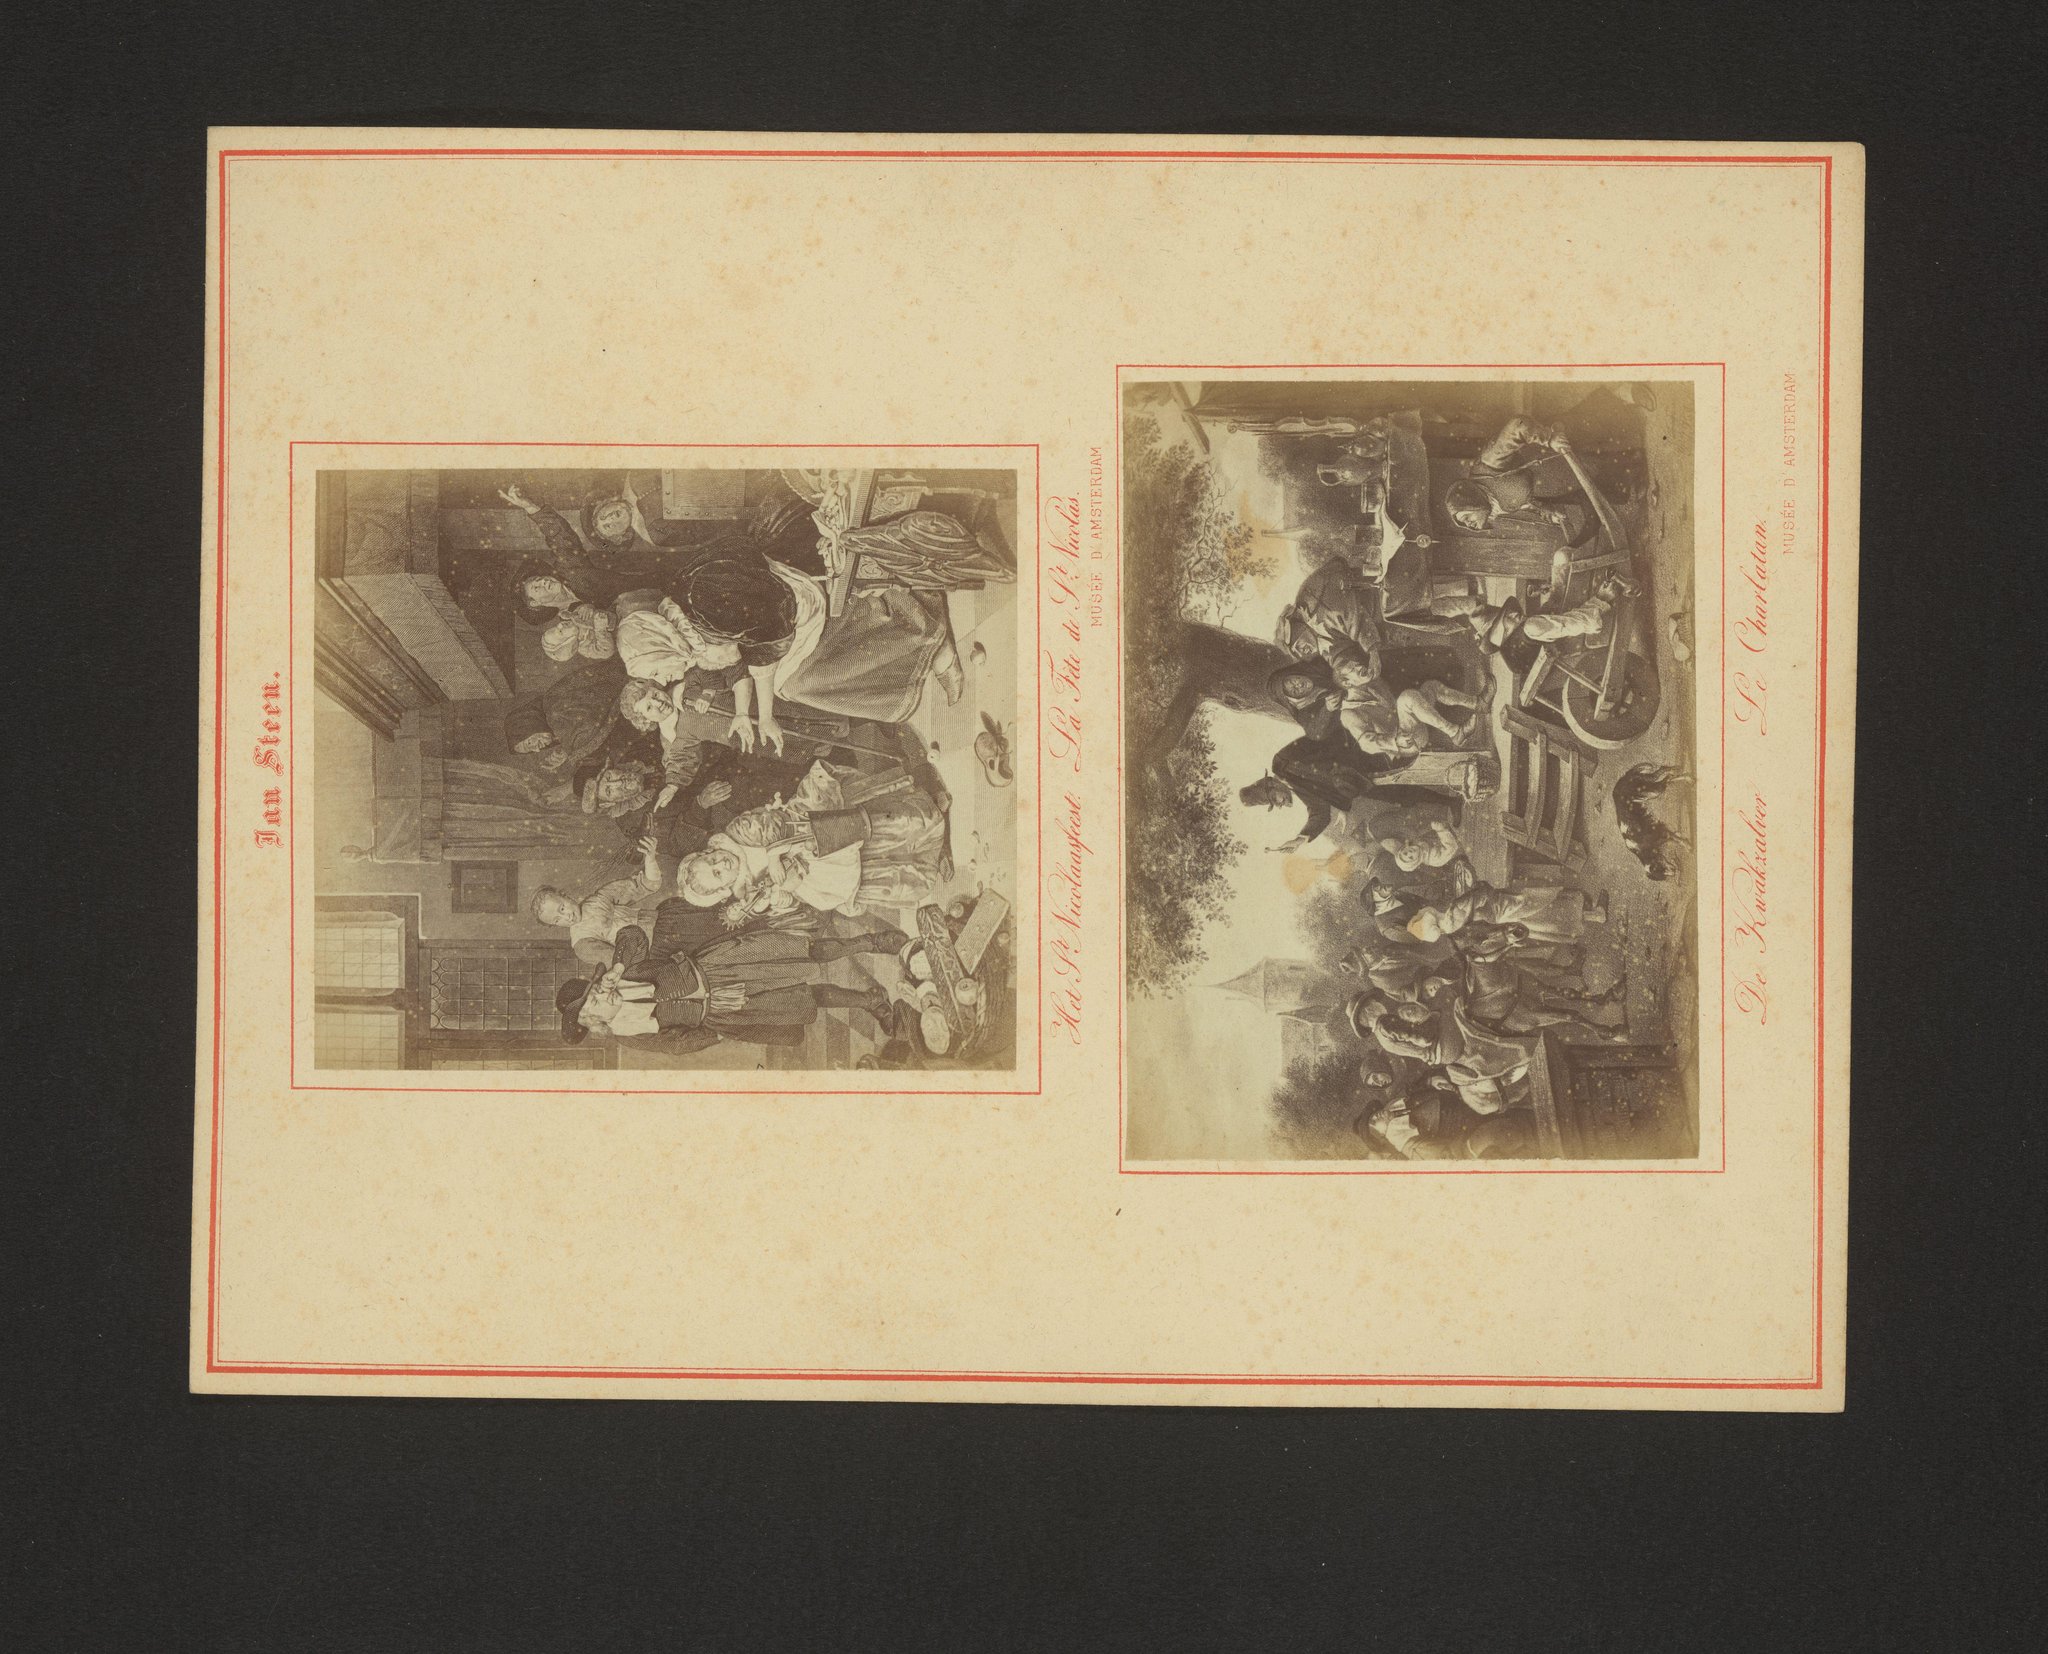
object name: photograph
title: Jan Steen - De kwakzalver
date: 1866-1874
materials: cardboard, photographic support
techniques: albumen print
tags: quack, charlatan, mountebank, 'saltimbanco', (playing with) dolls, weeping, festivities on st. nicholas (eve) (december 5), quack extracting teeth or molars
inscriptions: annotation: ‘Musée d'Amsterdam’, annotation: ‘Musée d'Amsterdam’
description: Deze foto maakt deel uit van een omslag met 25 foto's.